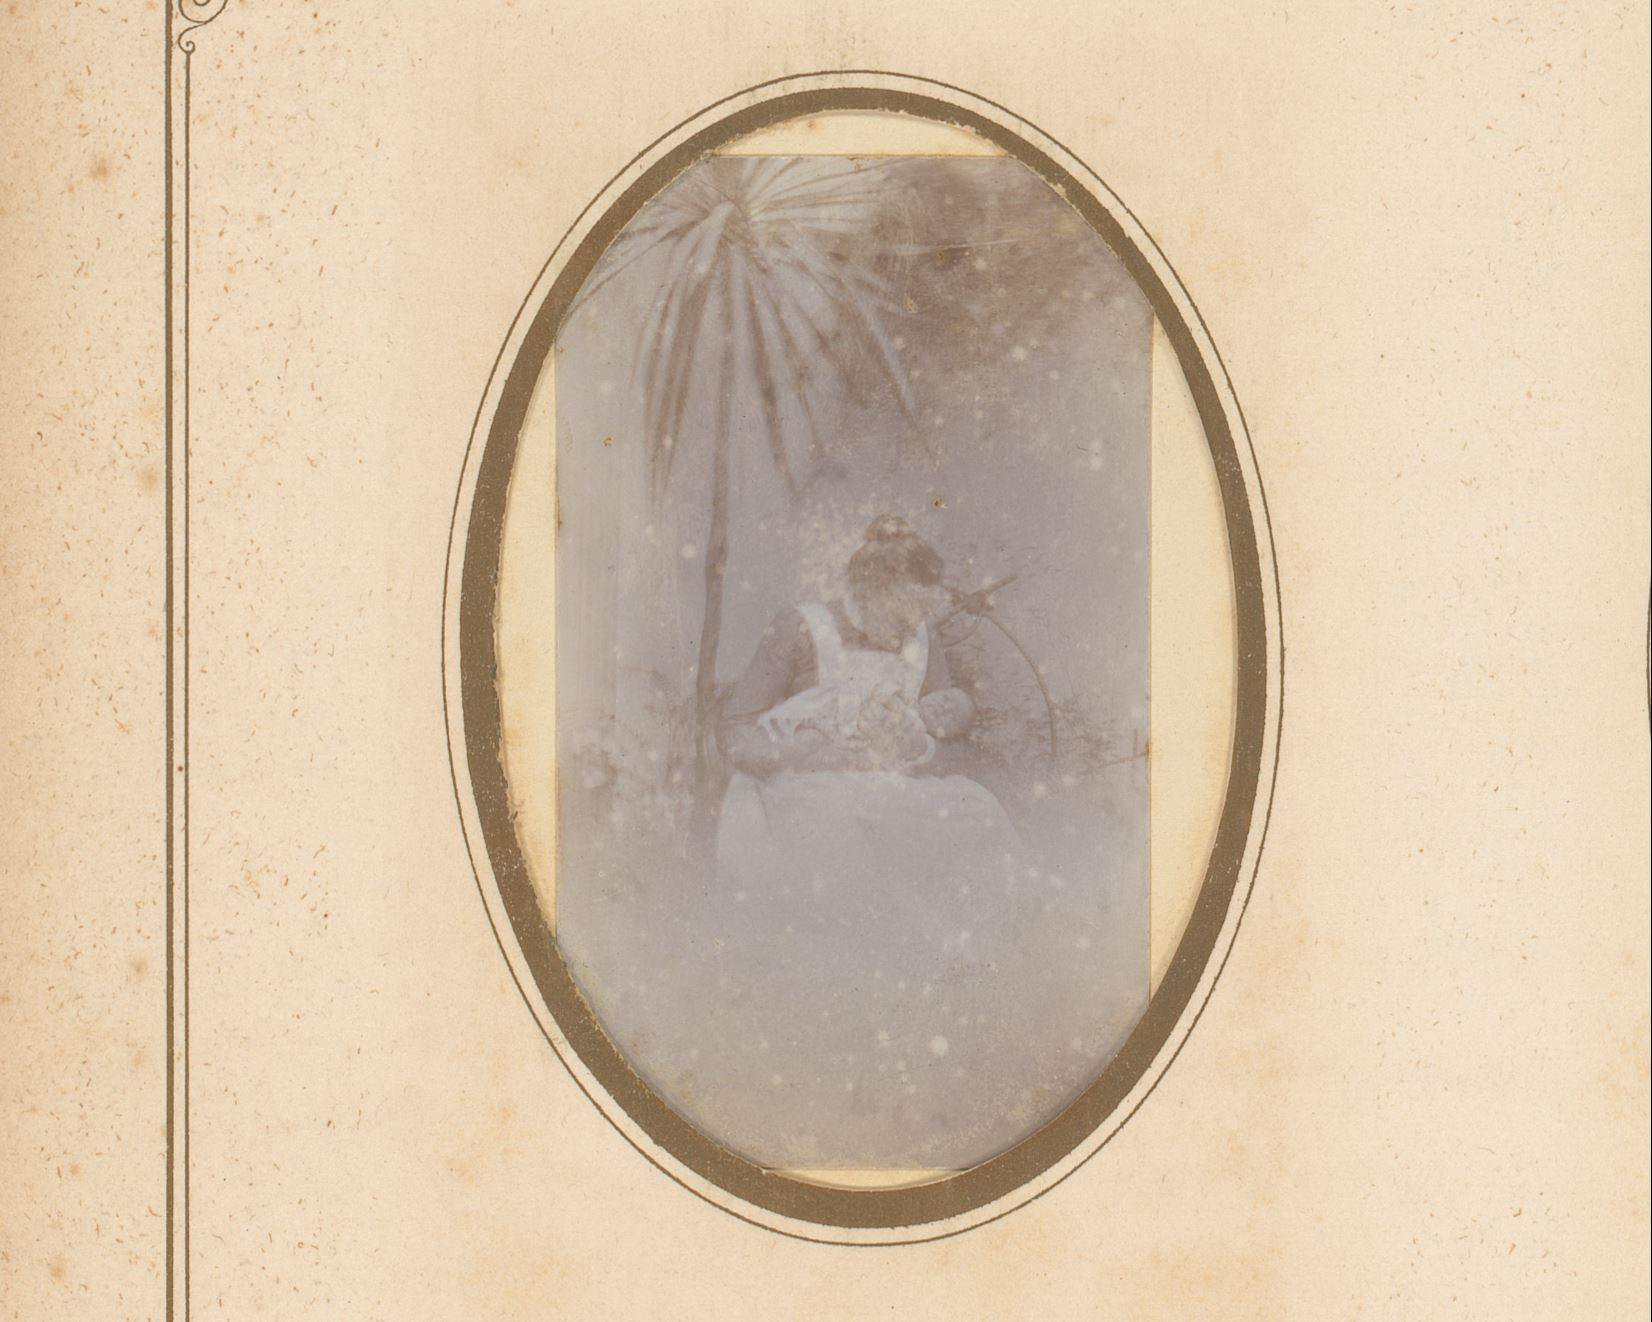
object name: photograph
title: Portret van een dienstbode met een baby op schoot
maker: Anonymous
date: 1880-1920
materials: cardboard, photographic support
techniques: collodion silver print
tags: adult woman, historical persons, infant, baby, house personnel, servants